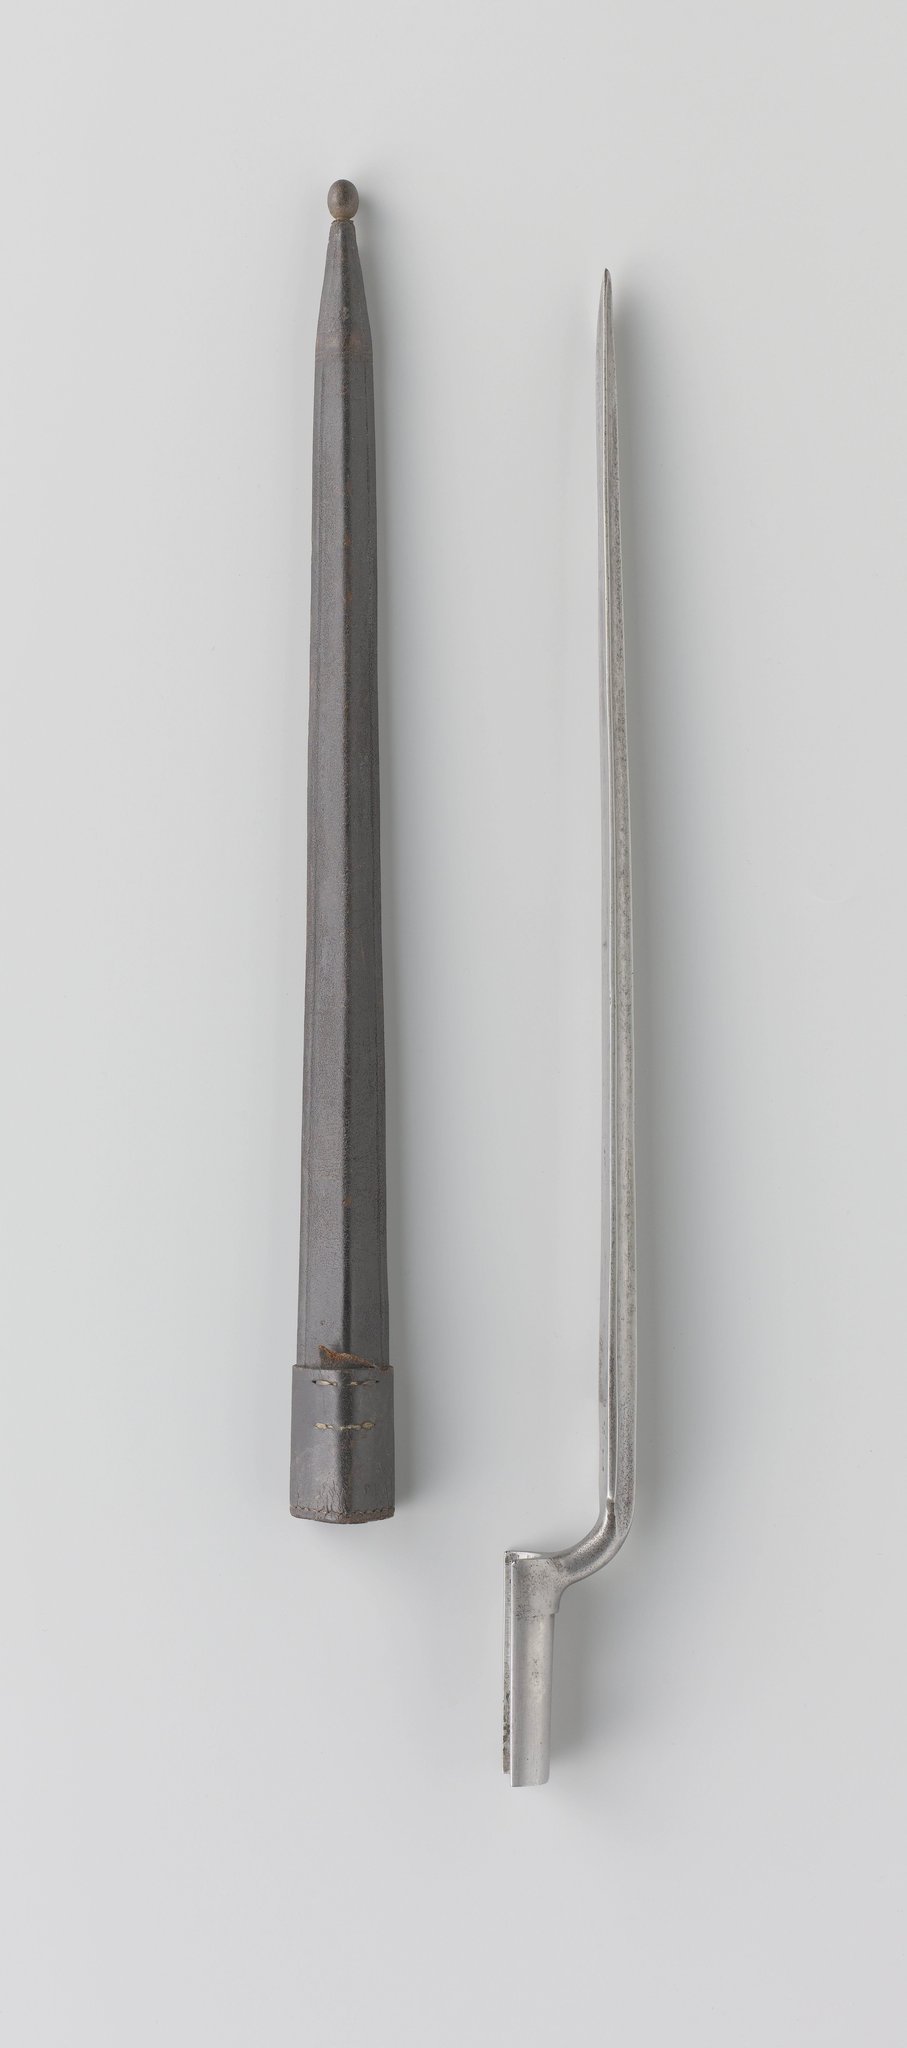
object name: bayonet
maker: joseph alexandre robert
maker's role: geweermaker, pistoolmaker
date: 1832-1835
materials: iron, leather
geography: paris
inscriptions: inscription: ‘FUSIL ROBERT / BREVETE / PARIS.N.62 L / 28 / K’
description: De bajonet heft een kling driehoekig in doorsnede en een bevestigingswijze gelijkaardig aan de gewone bajonetsluiting, onvolledig. Geweer en bajonet zijn afzonderlijk aangetroffen, maar wegens nauwkeurig passen bij elkaar gebracht.